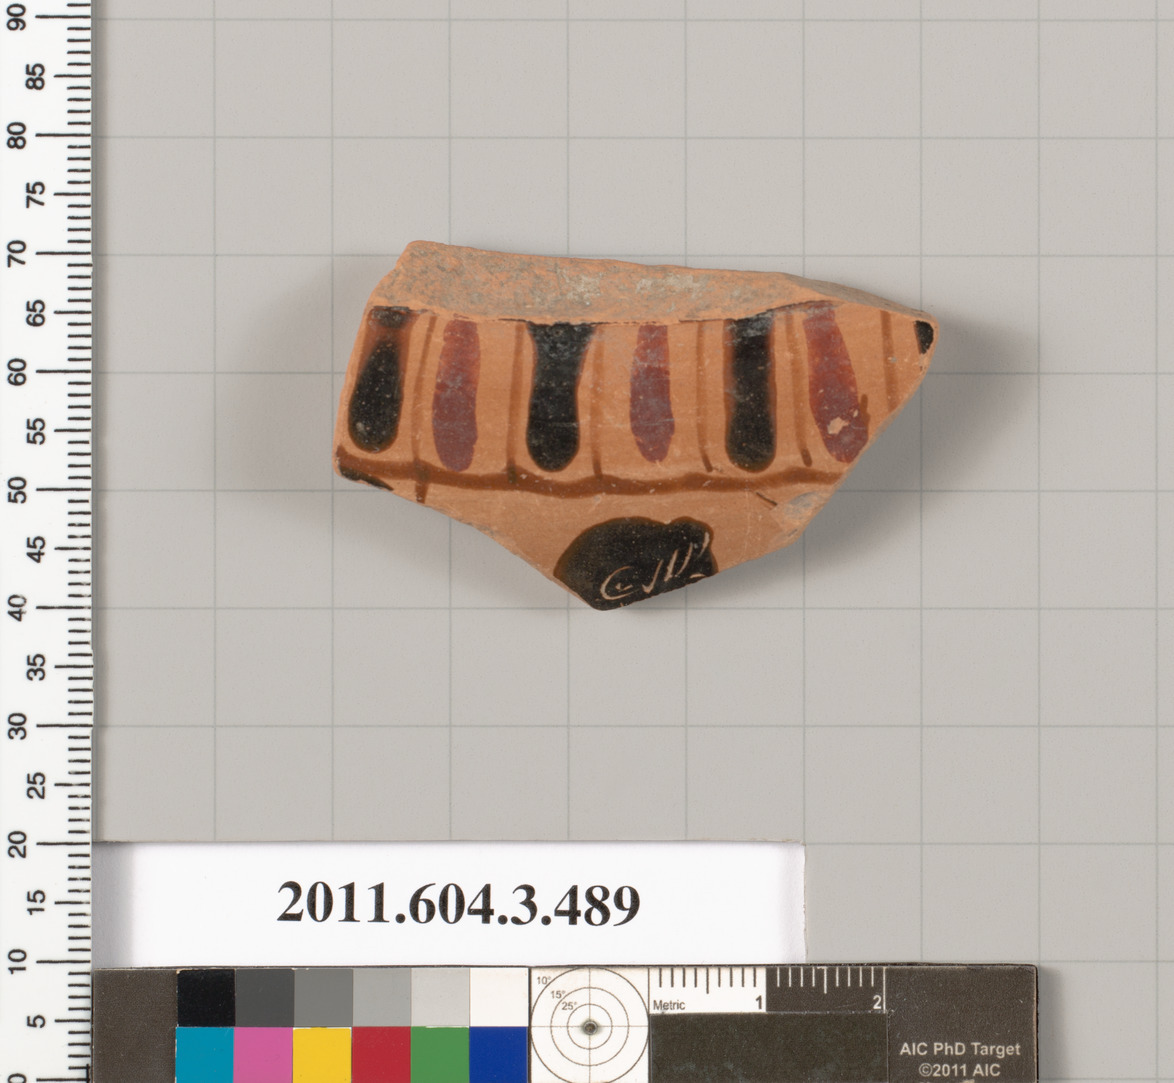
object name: column krater fragment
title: Terracotta fragment of a column-krater (bowl for mixing wine and water)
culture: greek, attic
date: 567-535 BCE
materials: terracotta